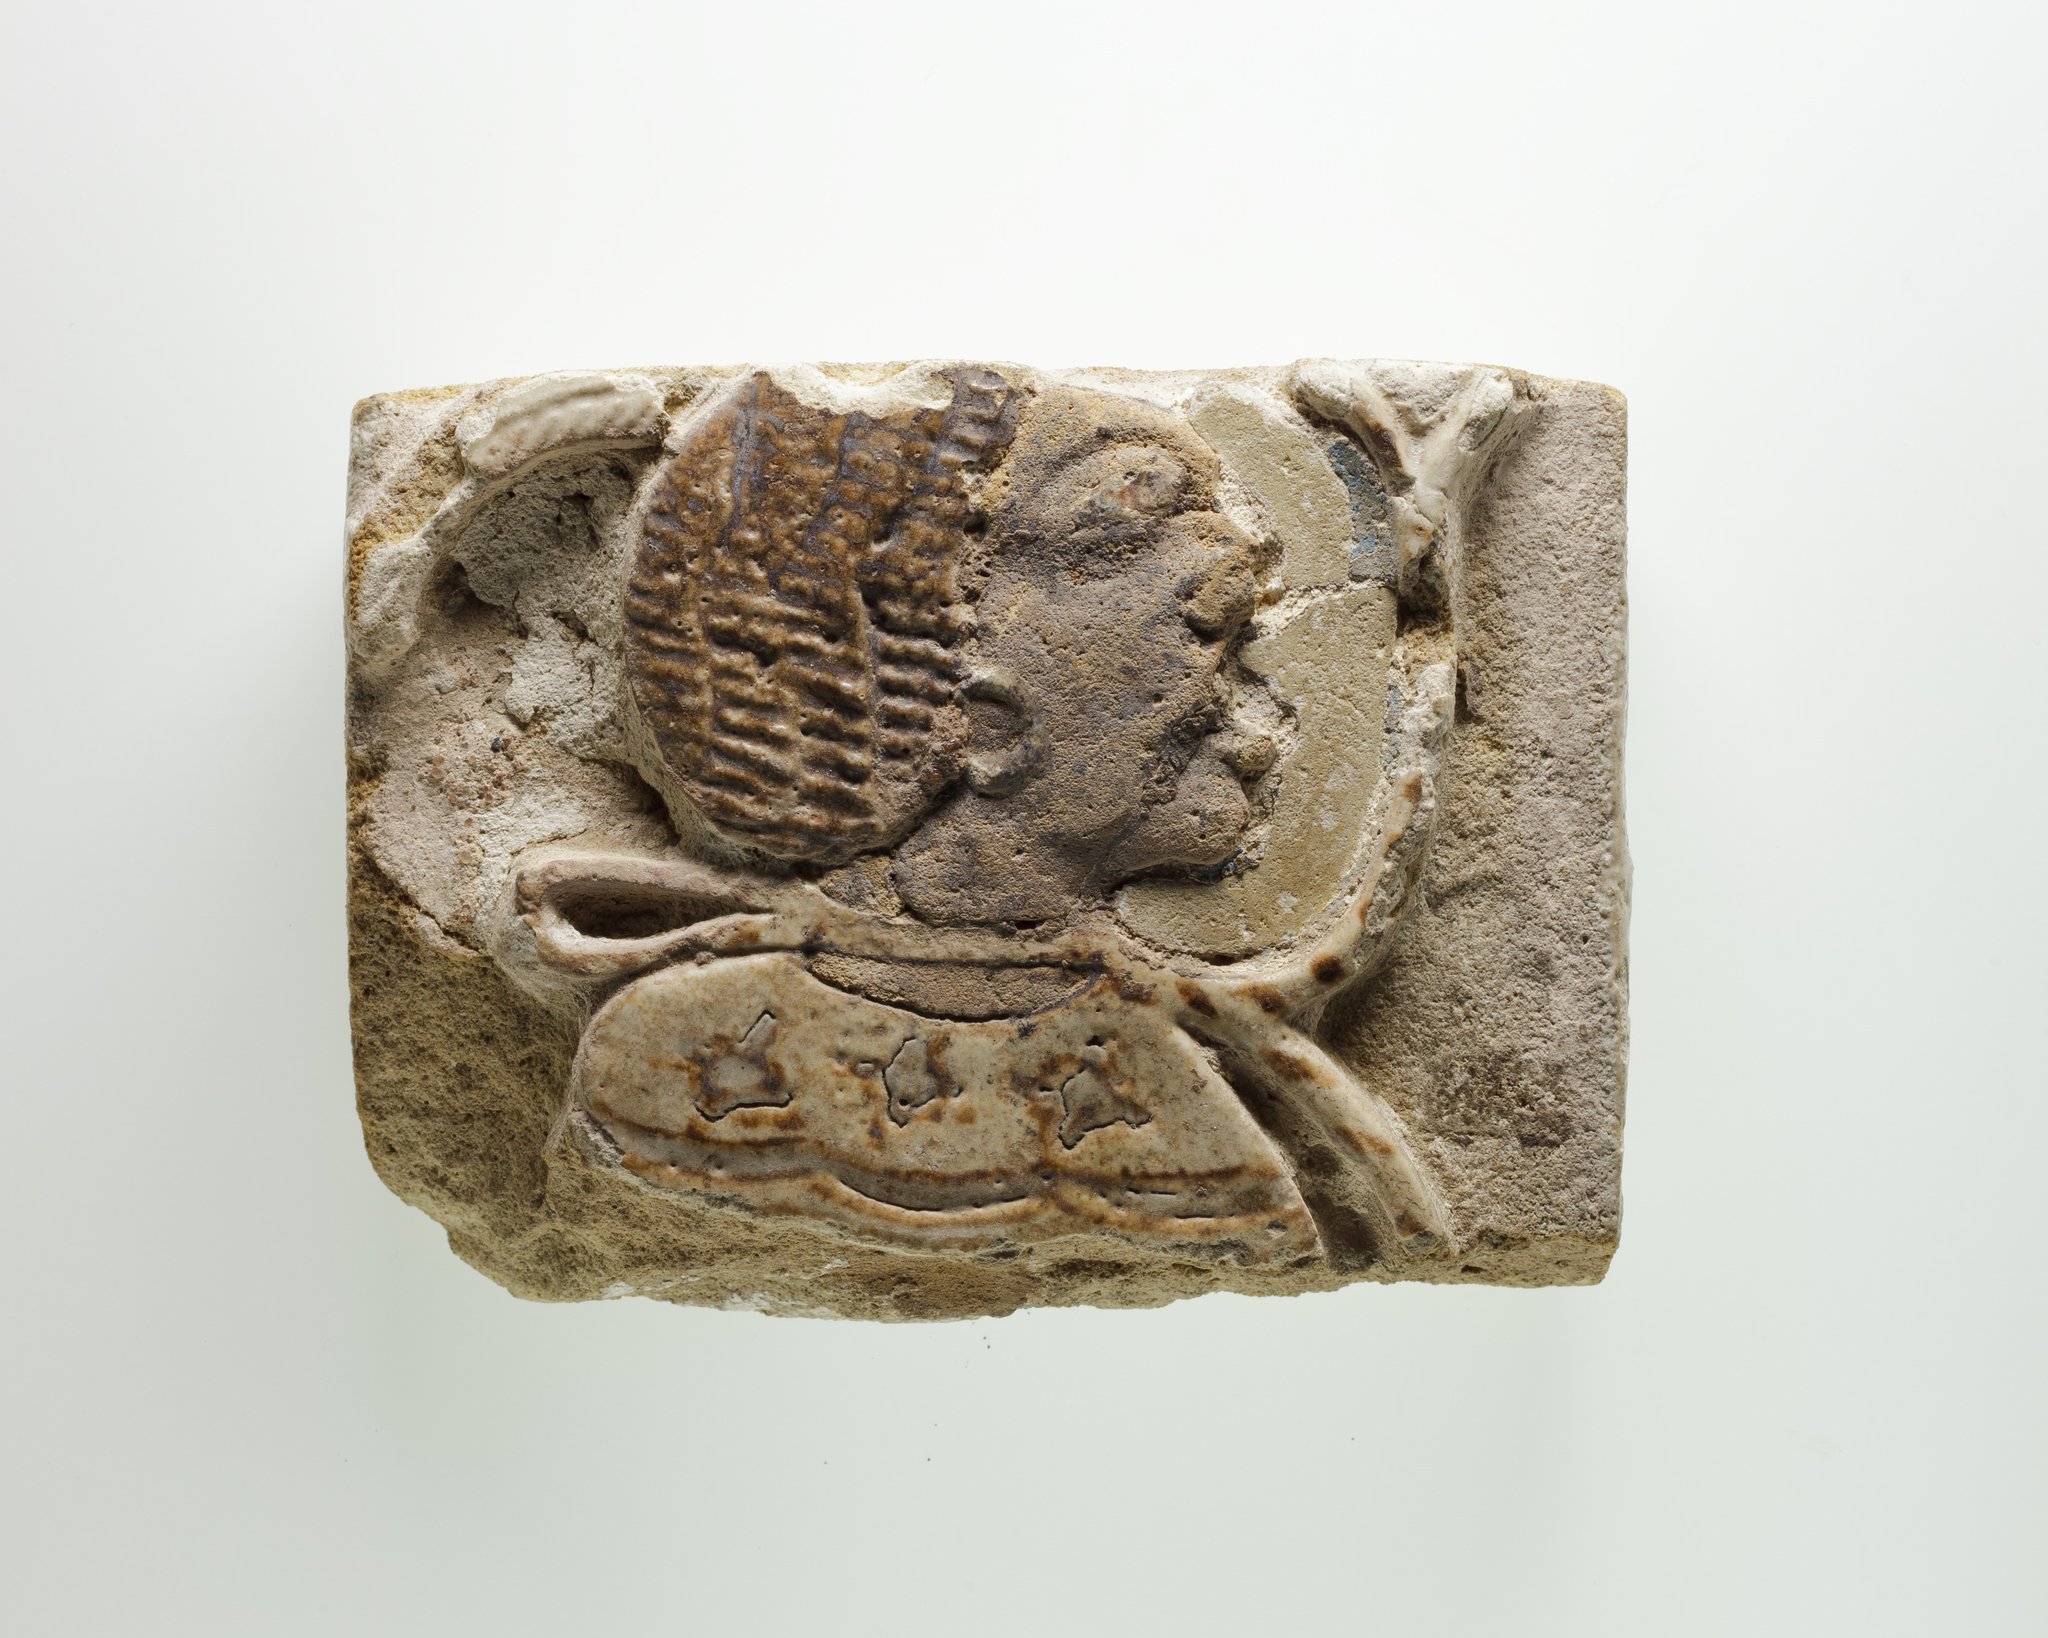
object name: tile fragment, head of prisoner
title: Tile fragment with a head of a prisoner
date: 1200-1085 BCE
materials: faience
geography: eastern delta